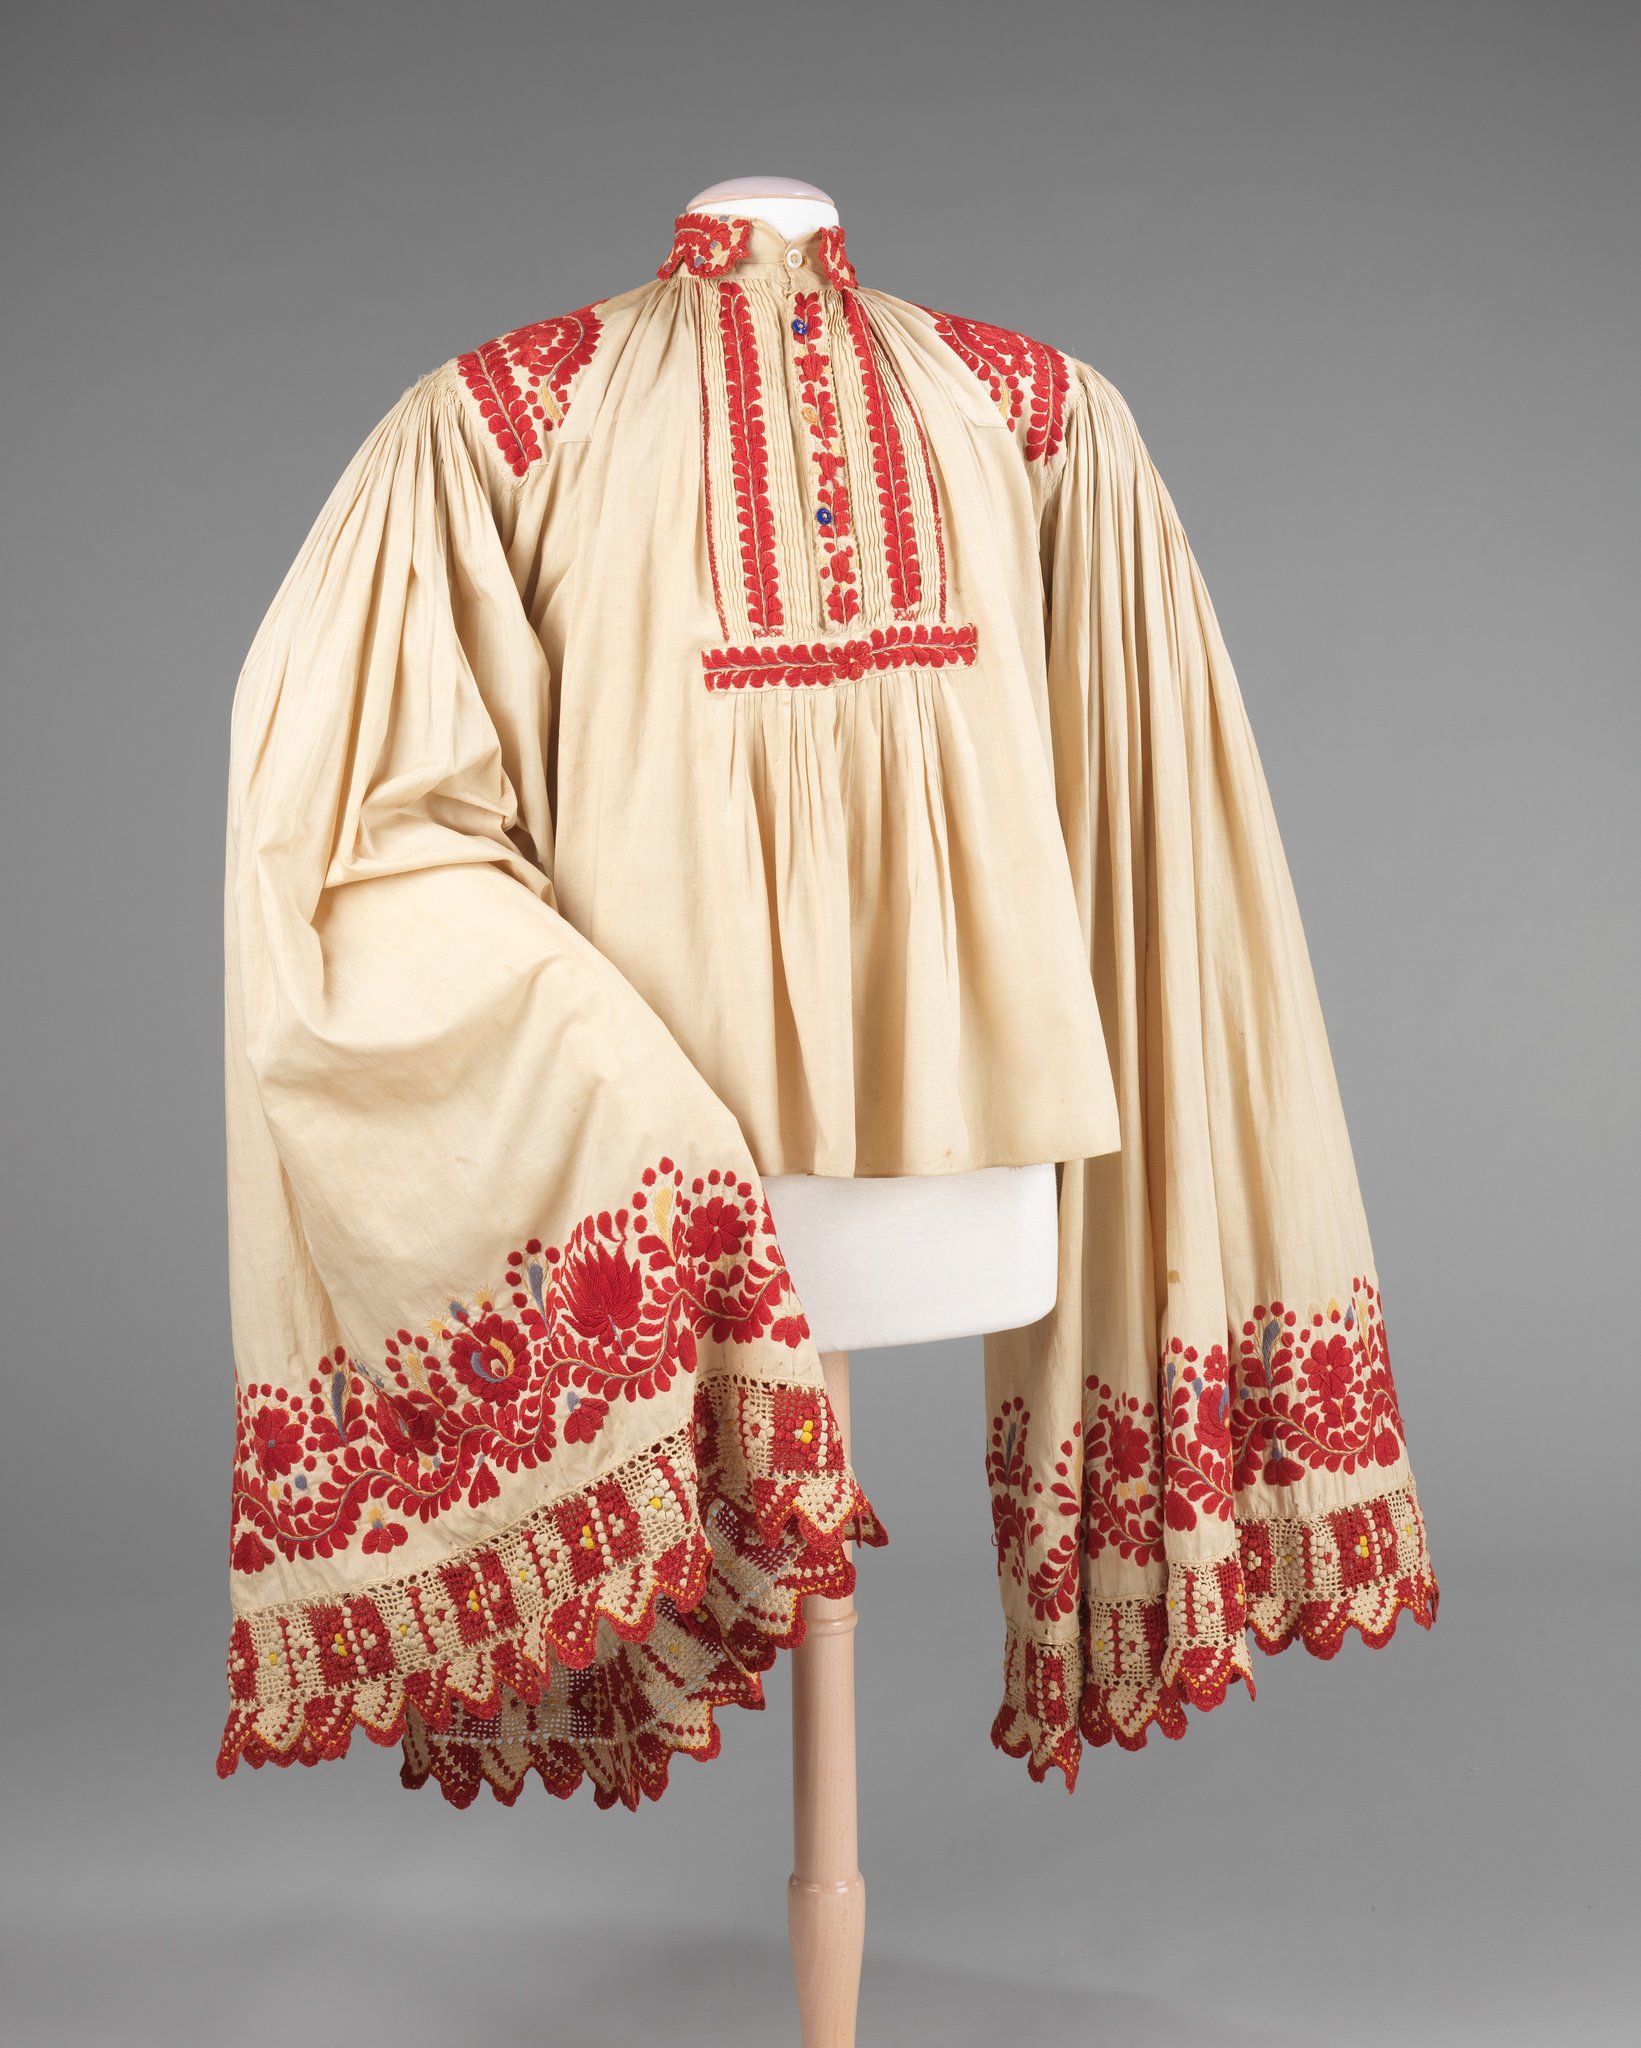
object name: shirt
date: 1867-1900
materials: cotton